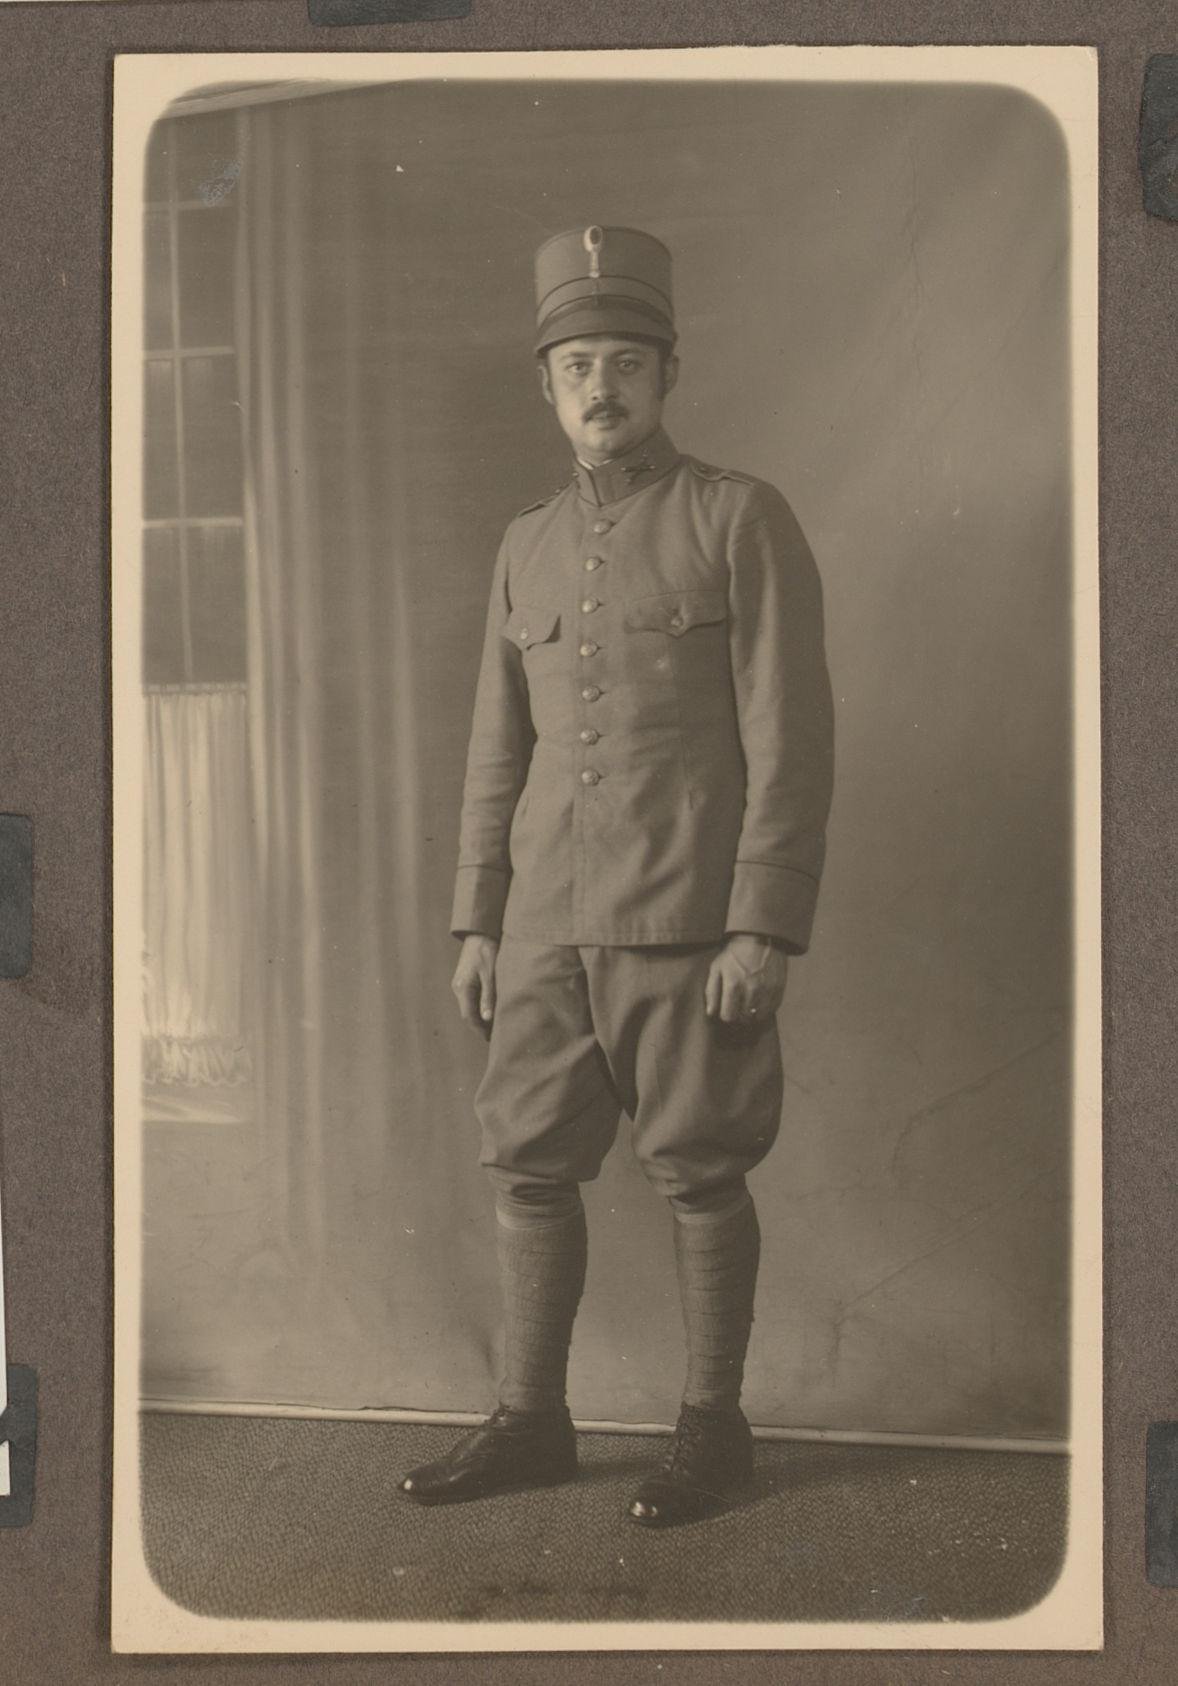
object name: photograph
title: Portret van Johannes van Zijll de Jong in legeruniform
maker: Anonymous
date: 1930-1935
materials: paper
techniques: gelatin silver print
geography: netherlands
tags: adult man, historical persons, (military) uniforms, netherlands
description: Gezien het uniform kon de rang van de geportretteerde mogelijk wachtmeester van het Korps Rijdende Artillerie zijn geweest.